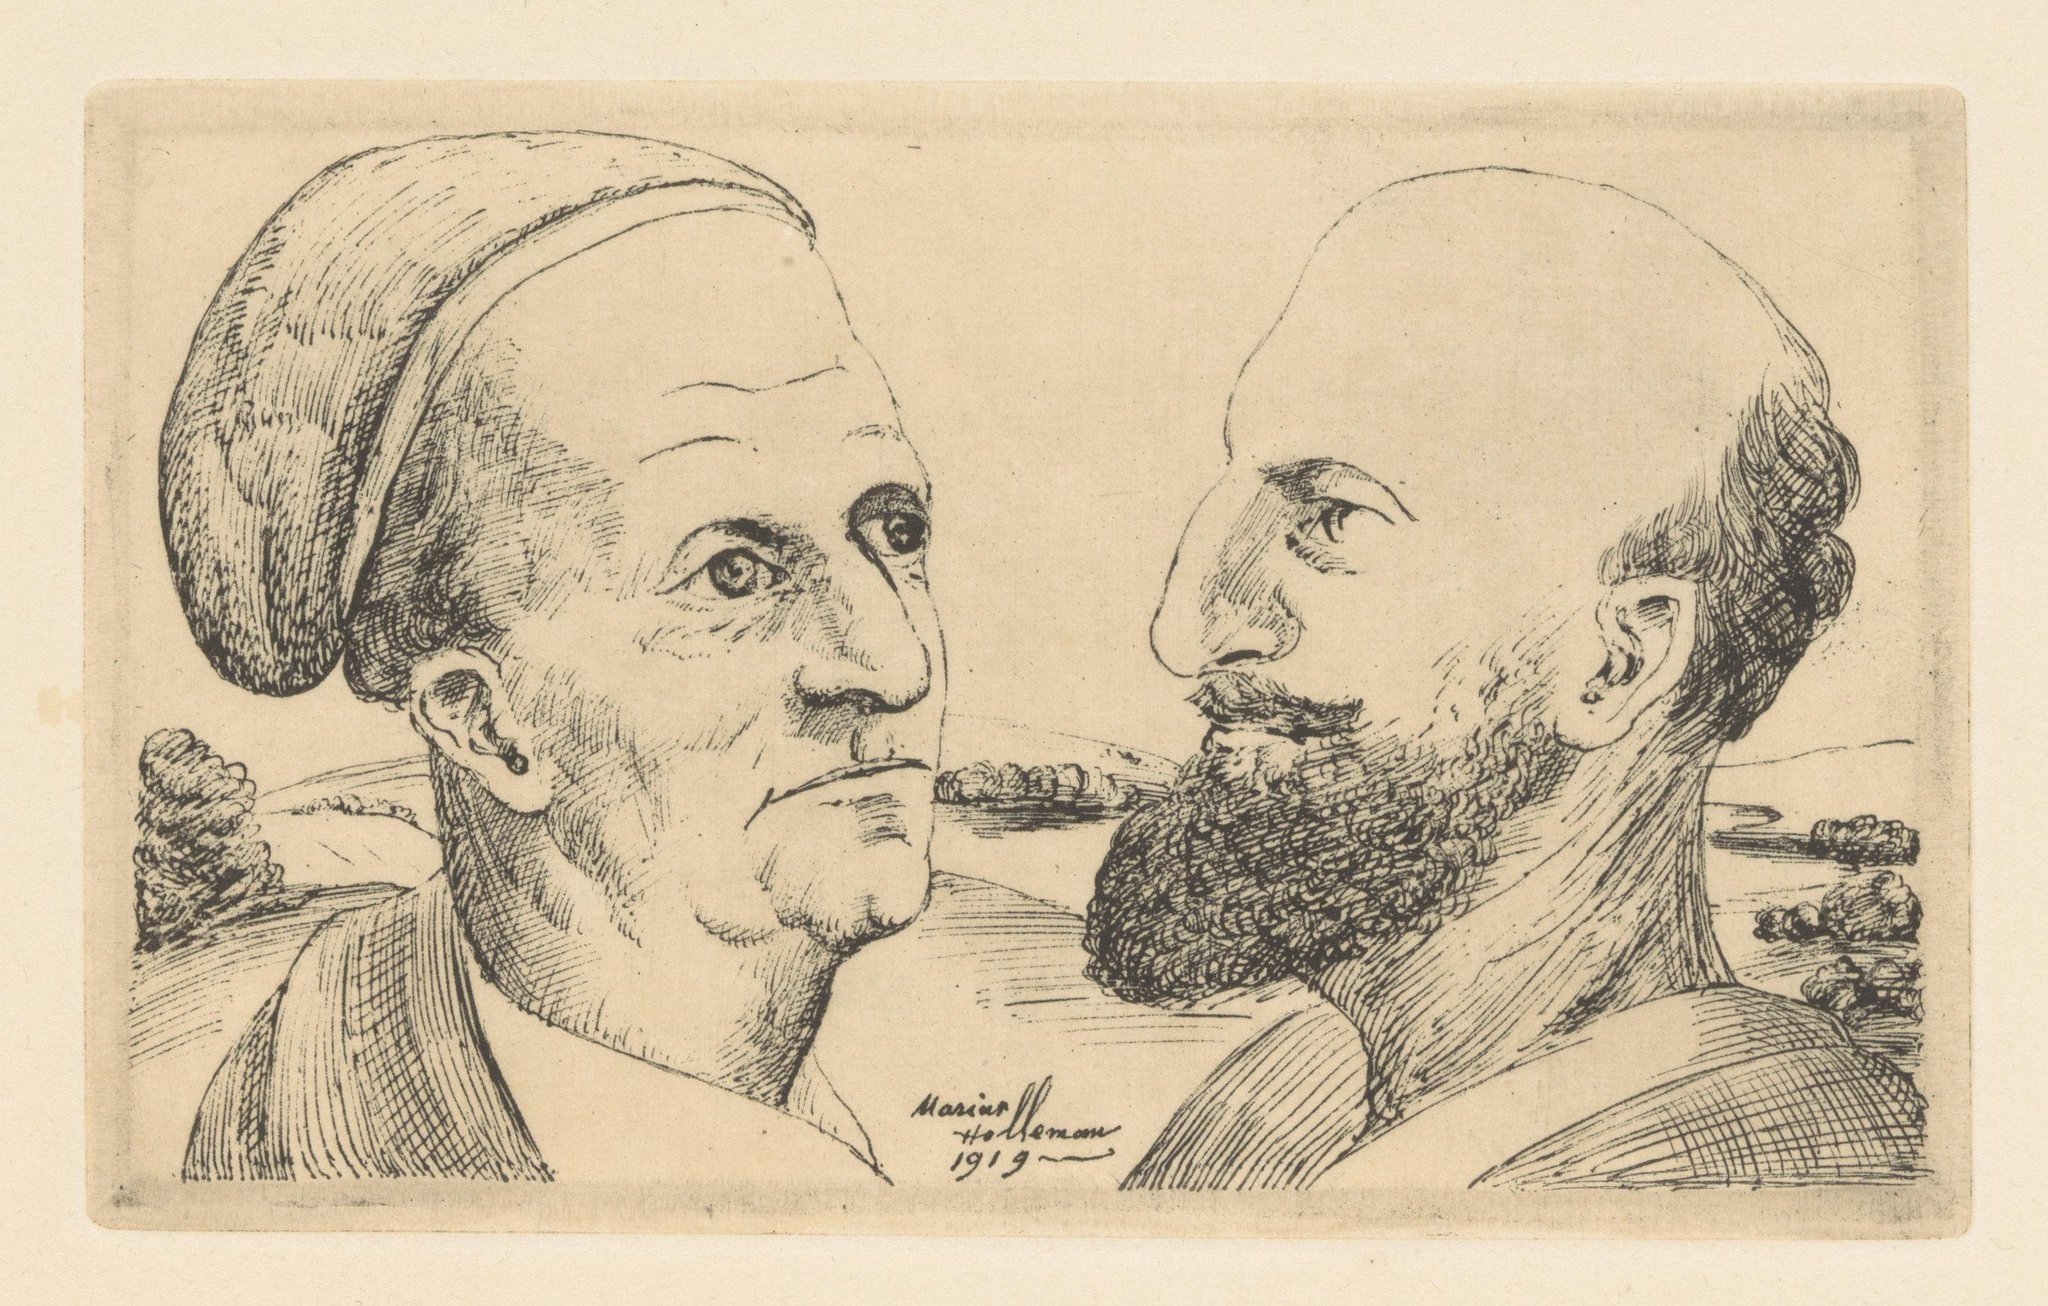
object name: print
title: Twee mannen in landschap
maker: marius holleman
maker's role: draughtsman, print maker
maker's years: 1878-1926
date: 1919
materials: paper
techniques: etching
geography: groningen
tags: landscapes in the temperate zone, head-gear: hat, baldness, beard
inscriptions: collector's mark: Lugt 2228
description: De linker man draagt een muts; de rechter heeft een baard en een kaal hoofd.